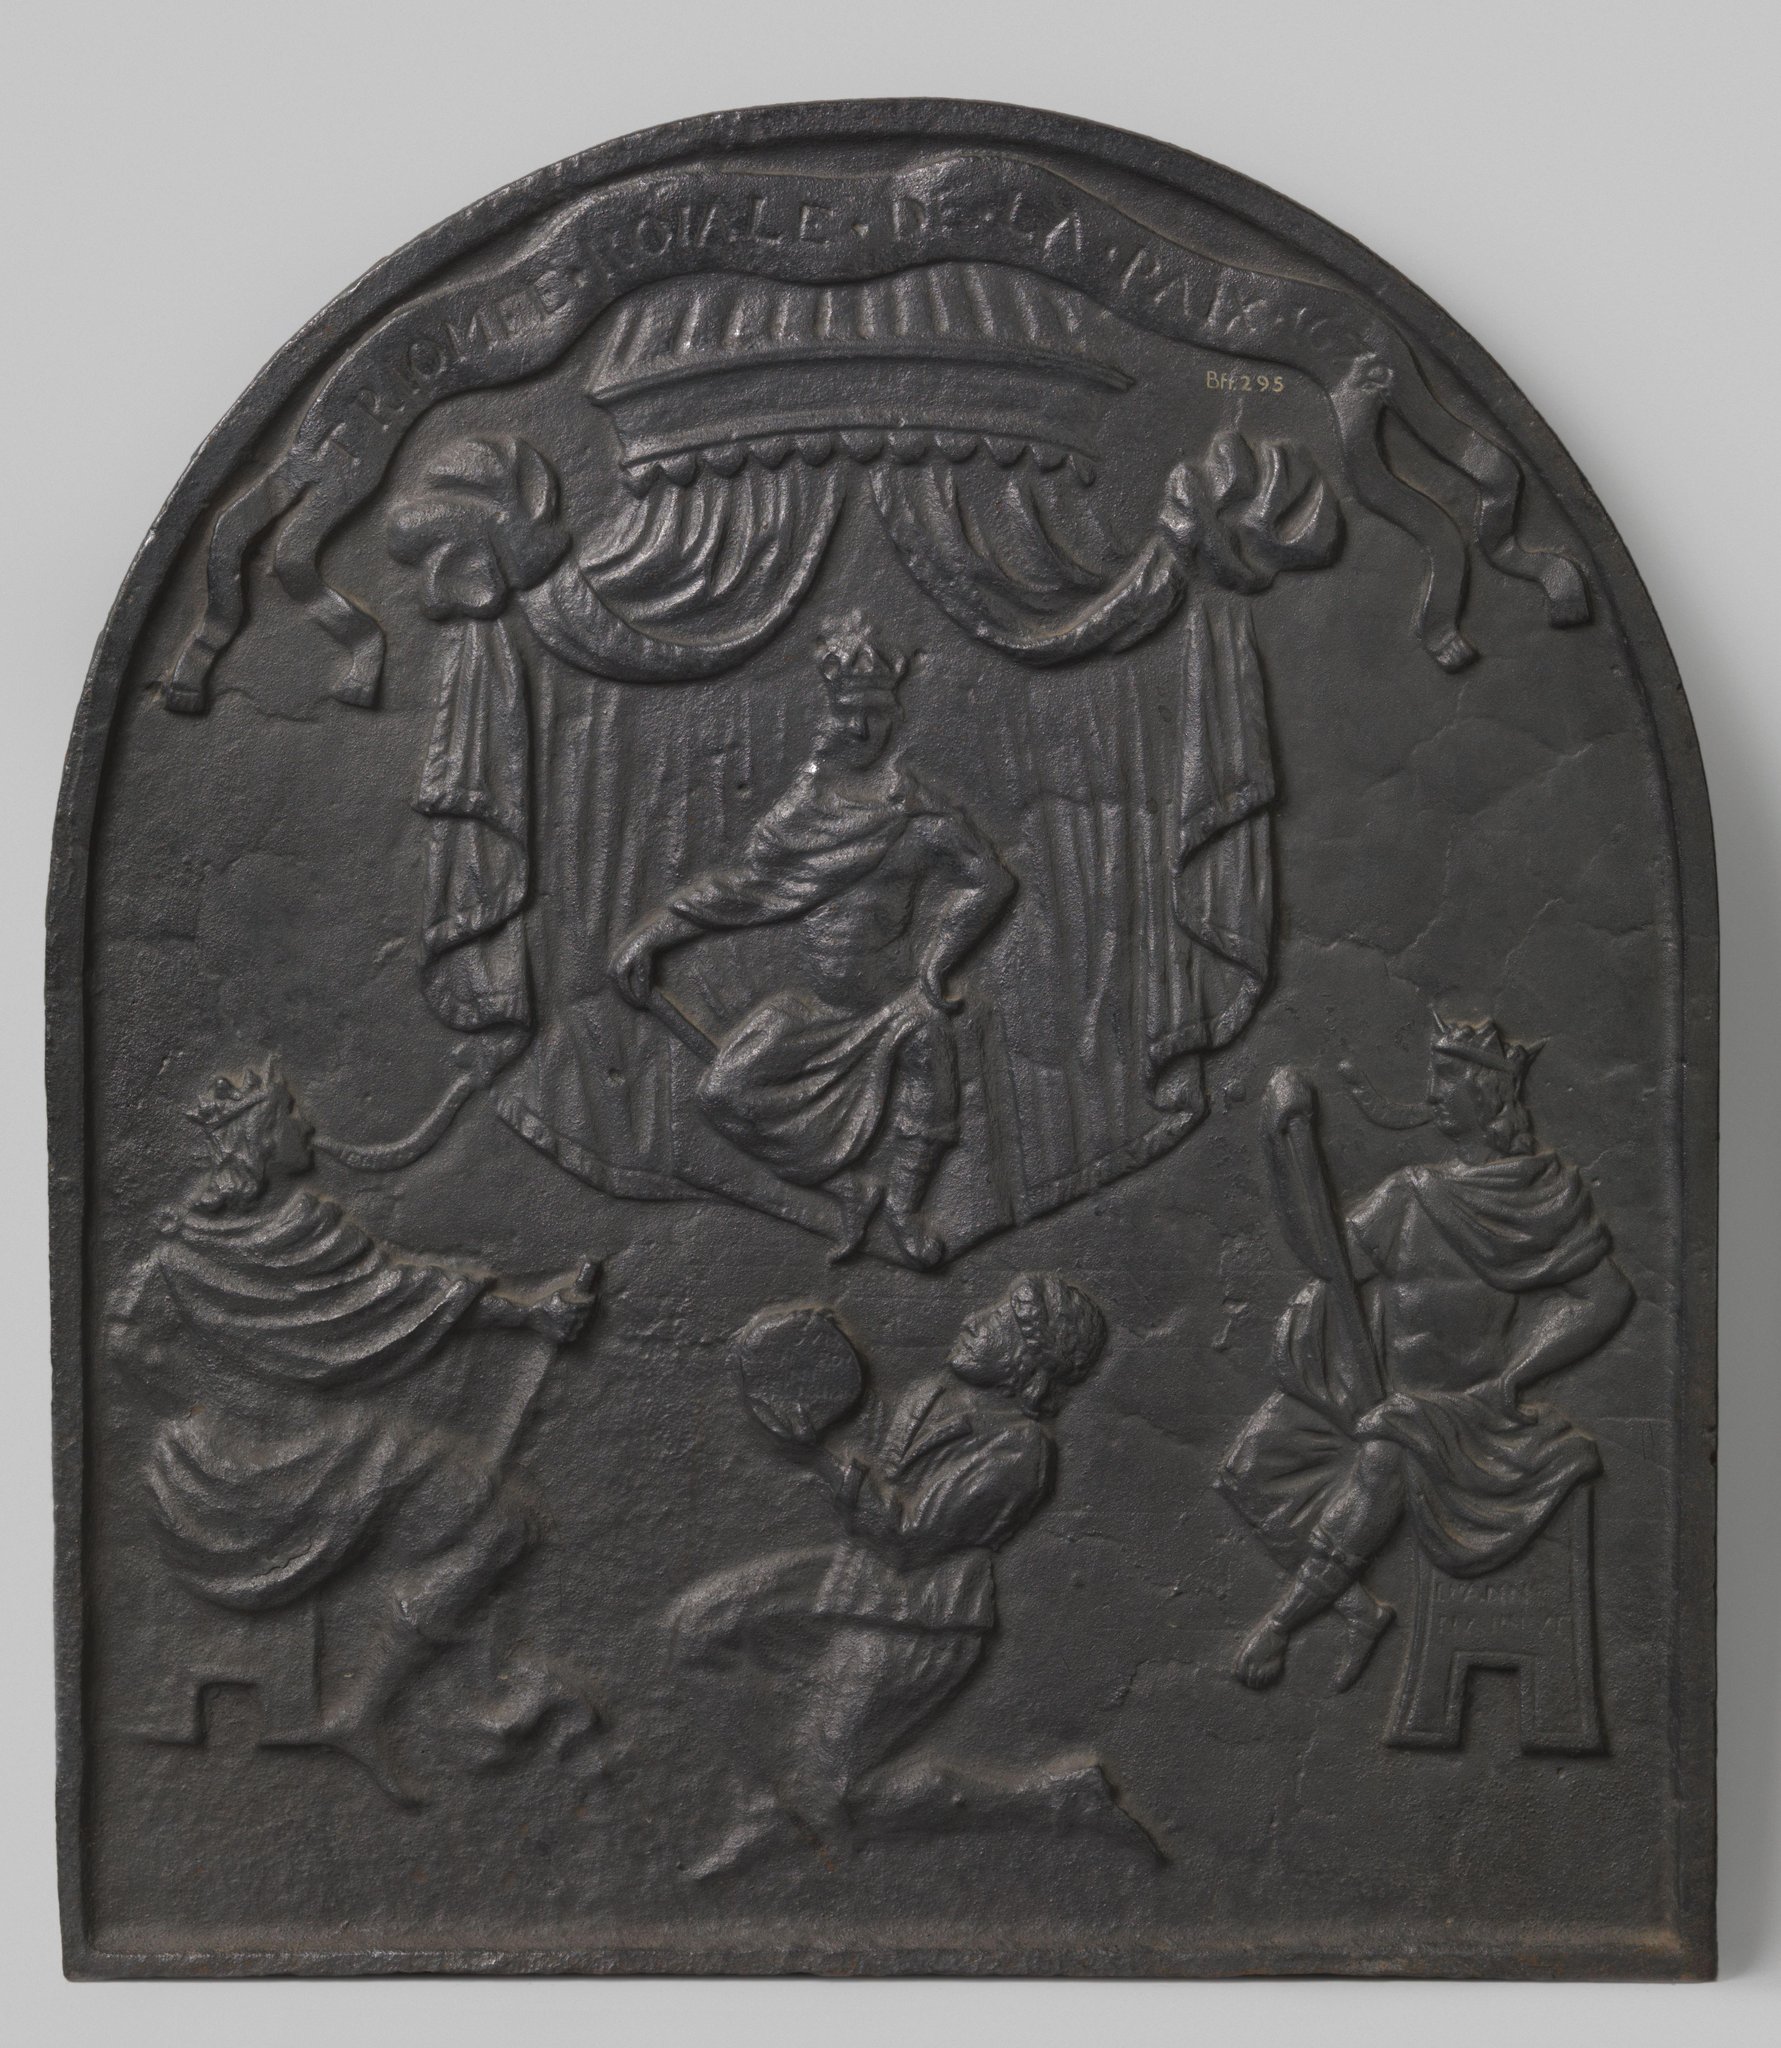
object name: fireback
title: Haardplaat met een triomfscène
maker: Anonymous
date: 1678-1700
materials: iron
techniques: casting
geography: france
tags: vrede van nijmegen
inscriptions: inscription: ‘TRIOMFE.ROYALE.DE.LA.PAIX.1678’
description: De vrede van Nijmegen maakte een eind aan de oorlog tussen Frankrijk en de Republiek, de 'guerre de Hollande' (1672-1678). Mogelijk is deze allegorie pro-Frans.